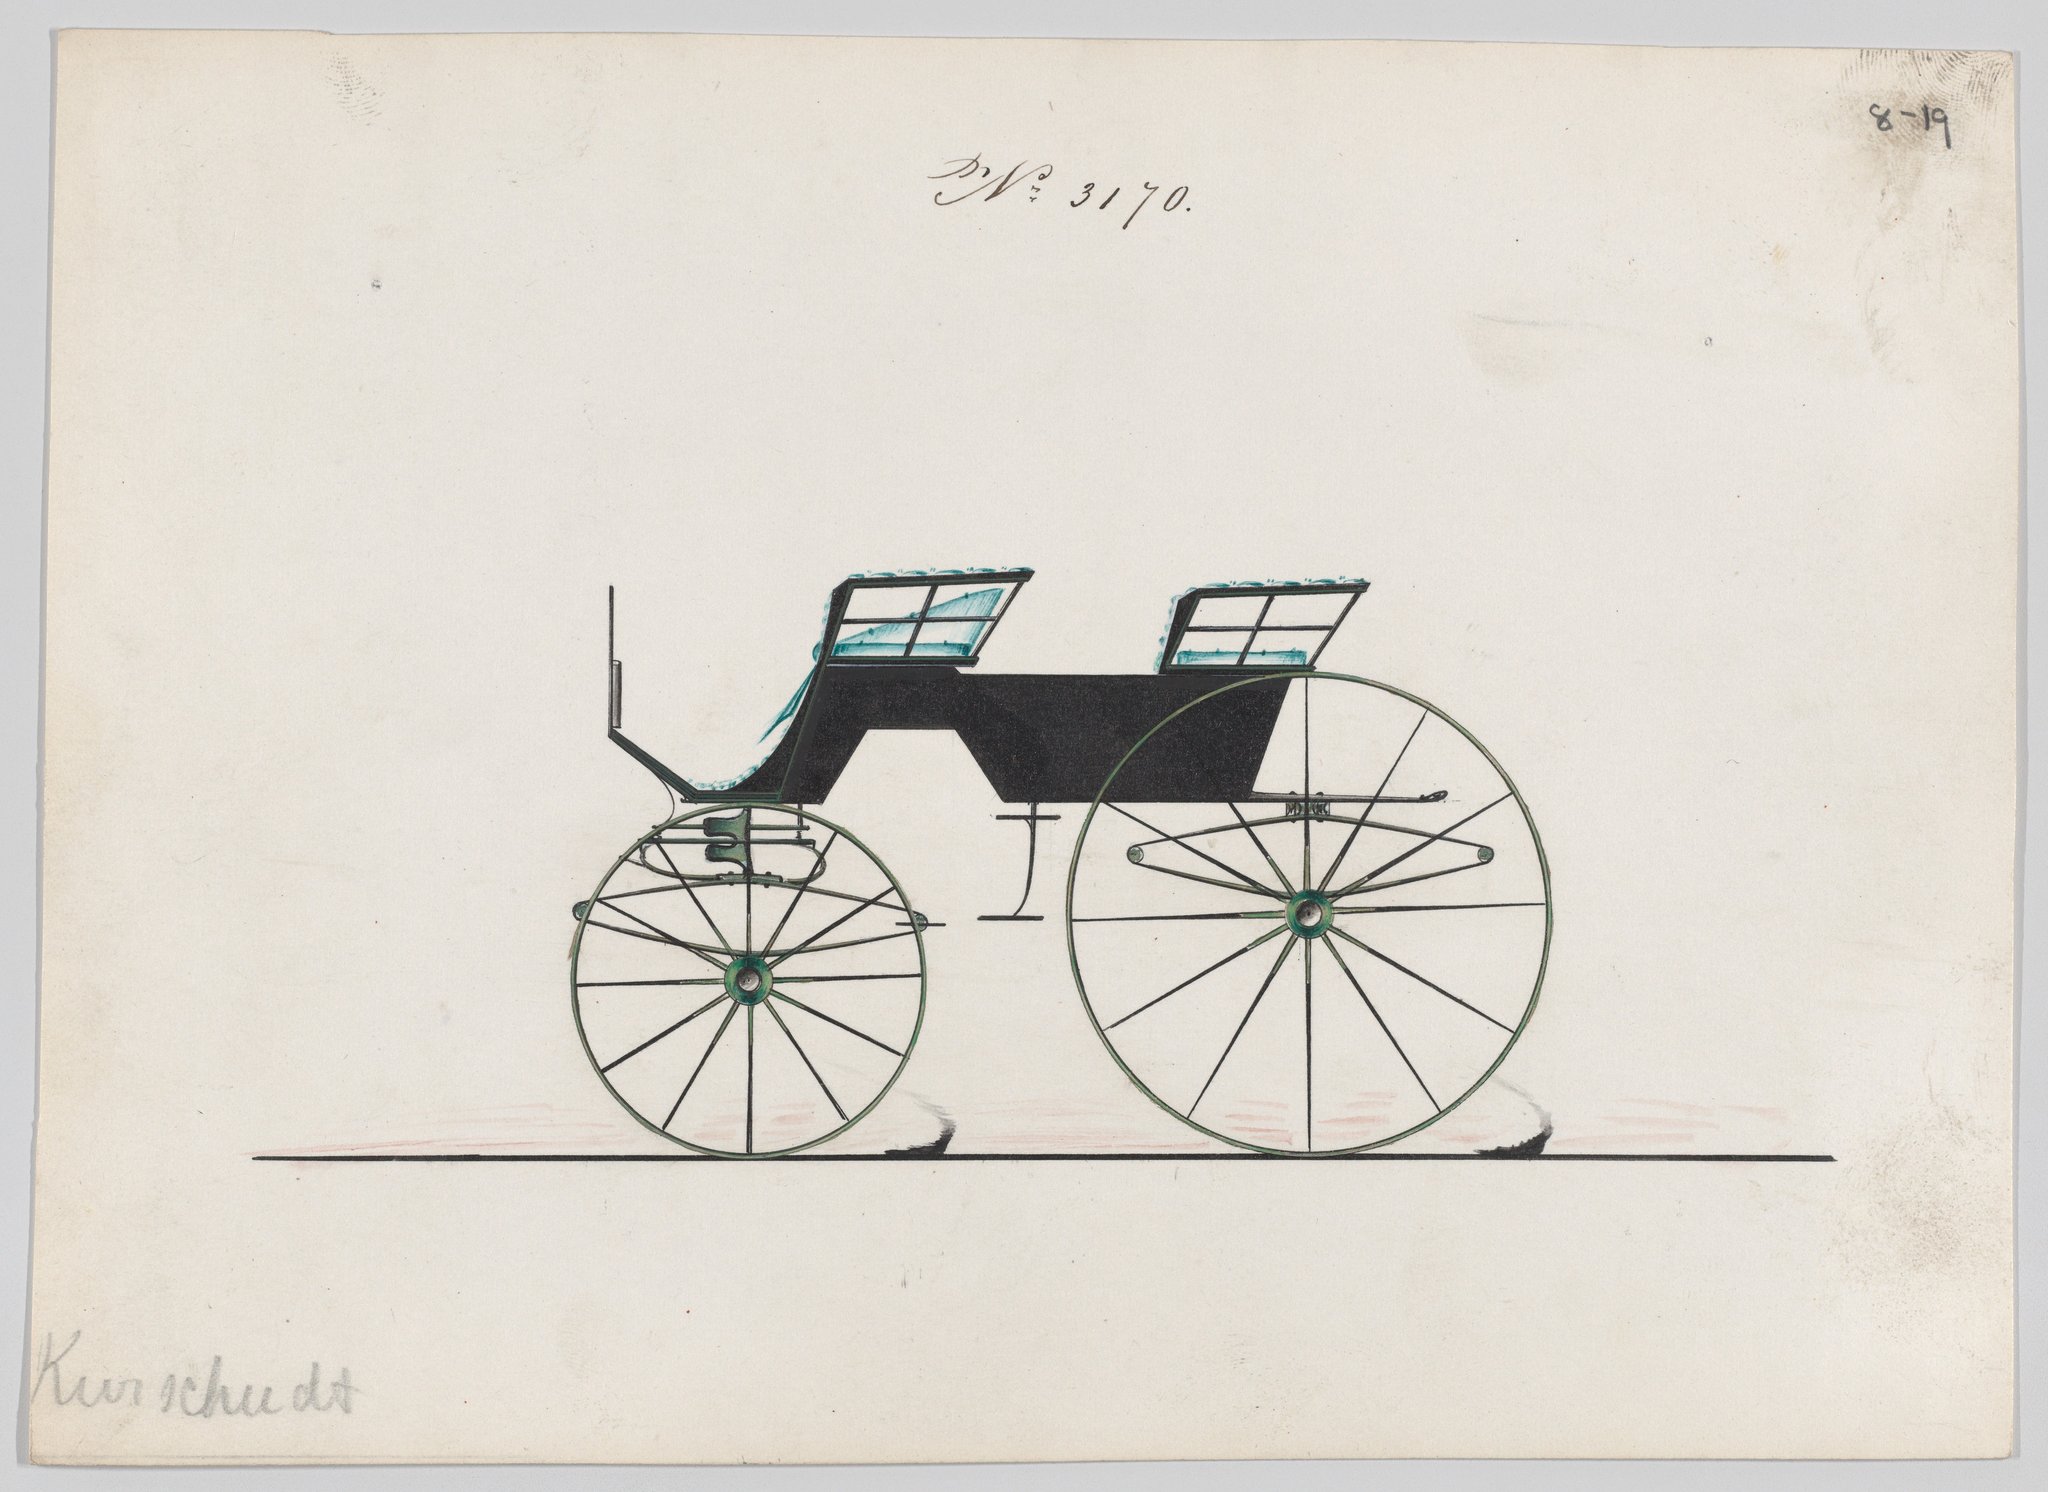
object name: drawing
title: Design for 4 seat Phaeton, no top, no. 3170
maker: brewster & co.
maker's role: manufacturer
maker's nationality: american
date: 1875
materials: gouache, gum arabic, ink, watercolor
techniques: pen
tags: carriages